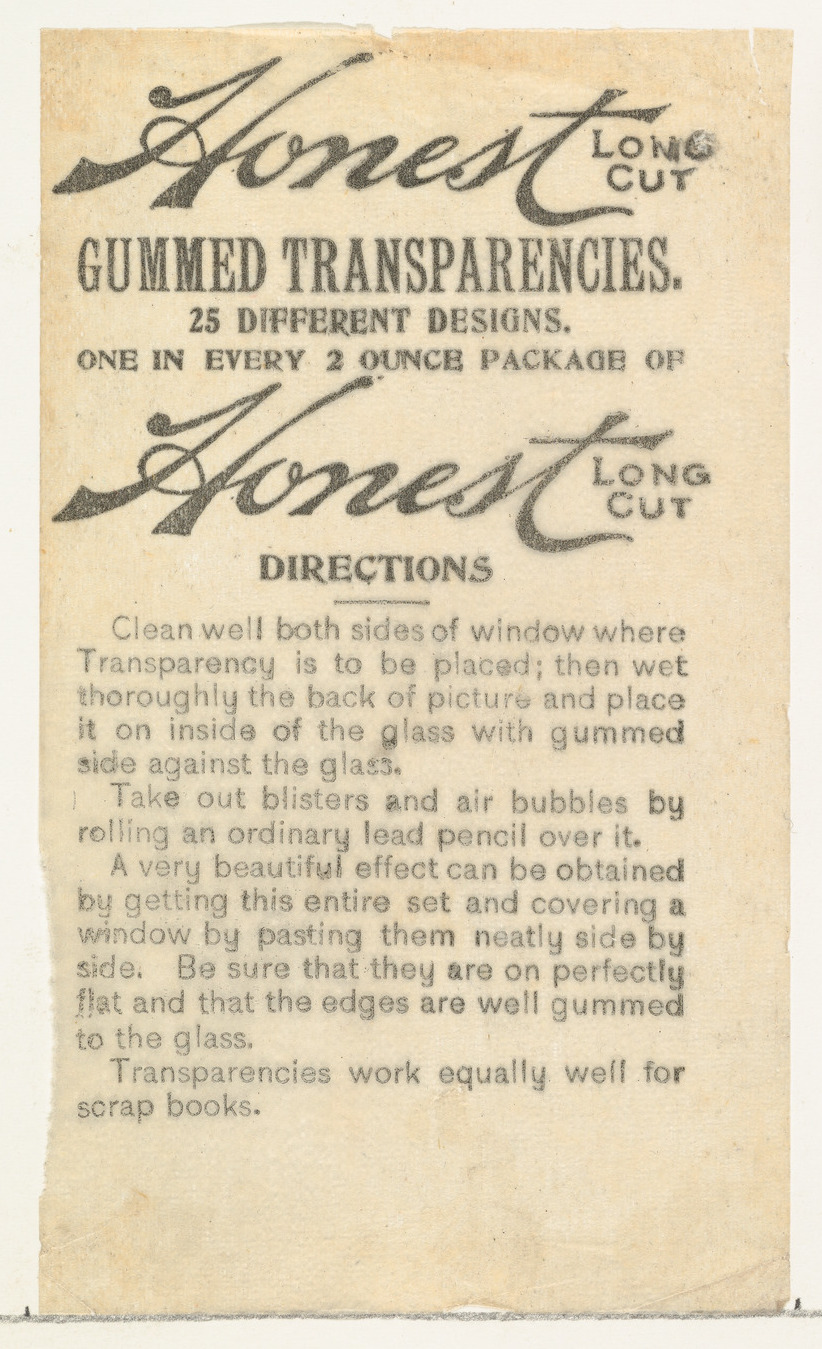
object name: print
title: Instruction insert from the Transparencies series (N137) issued by W. Duke, Sons & Co. to promote Honest Long Cut Tobacco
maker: w. duke, sons & co.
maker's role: publisher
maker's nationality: american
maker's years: 1870-1920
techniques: color lithograph